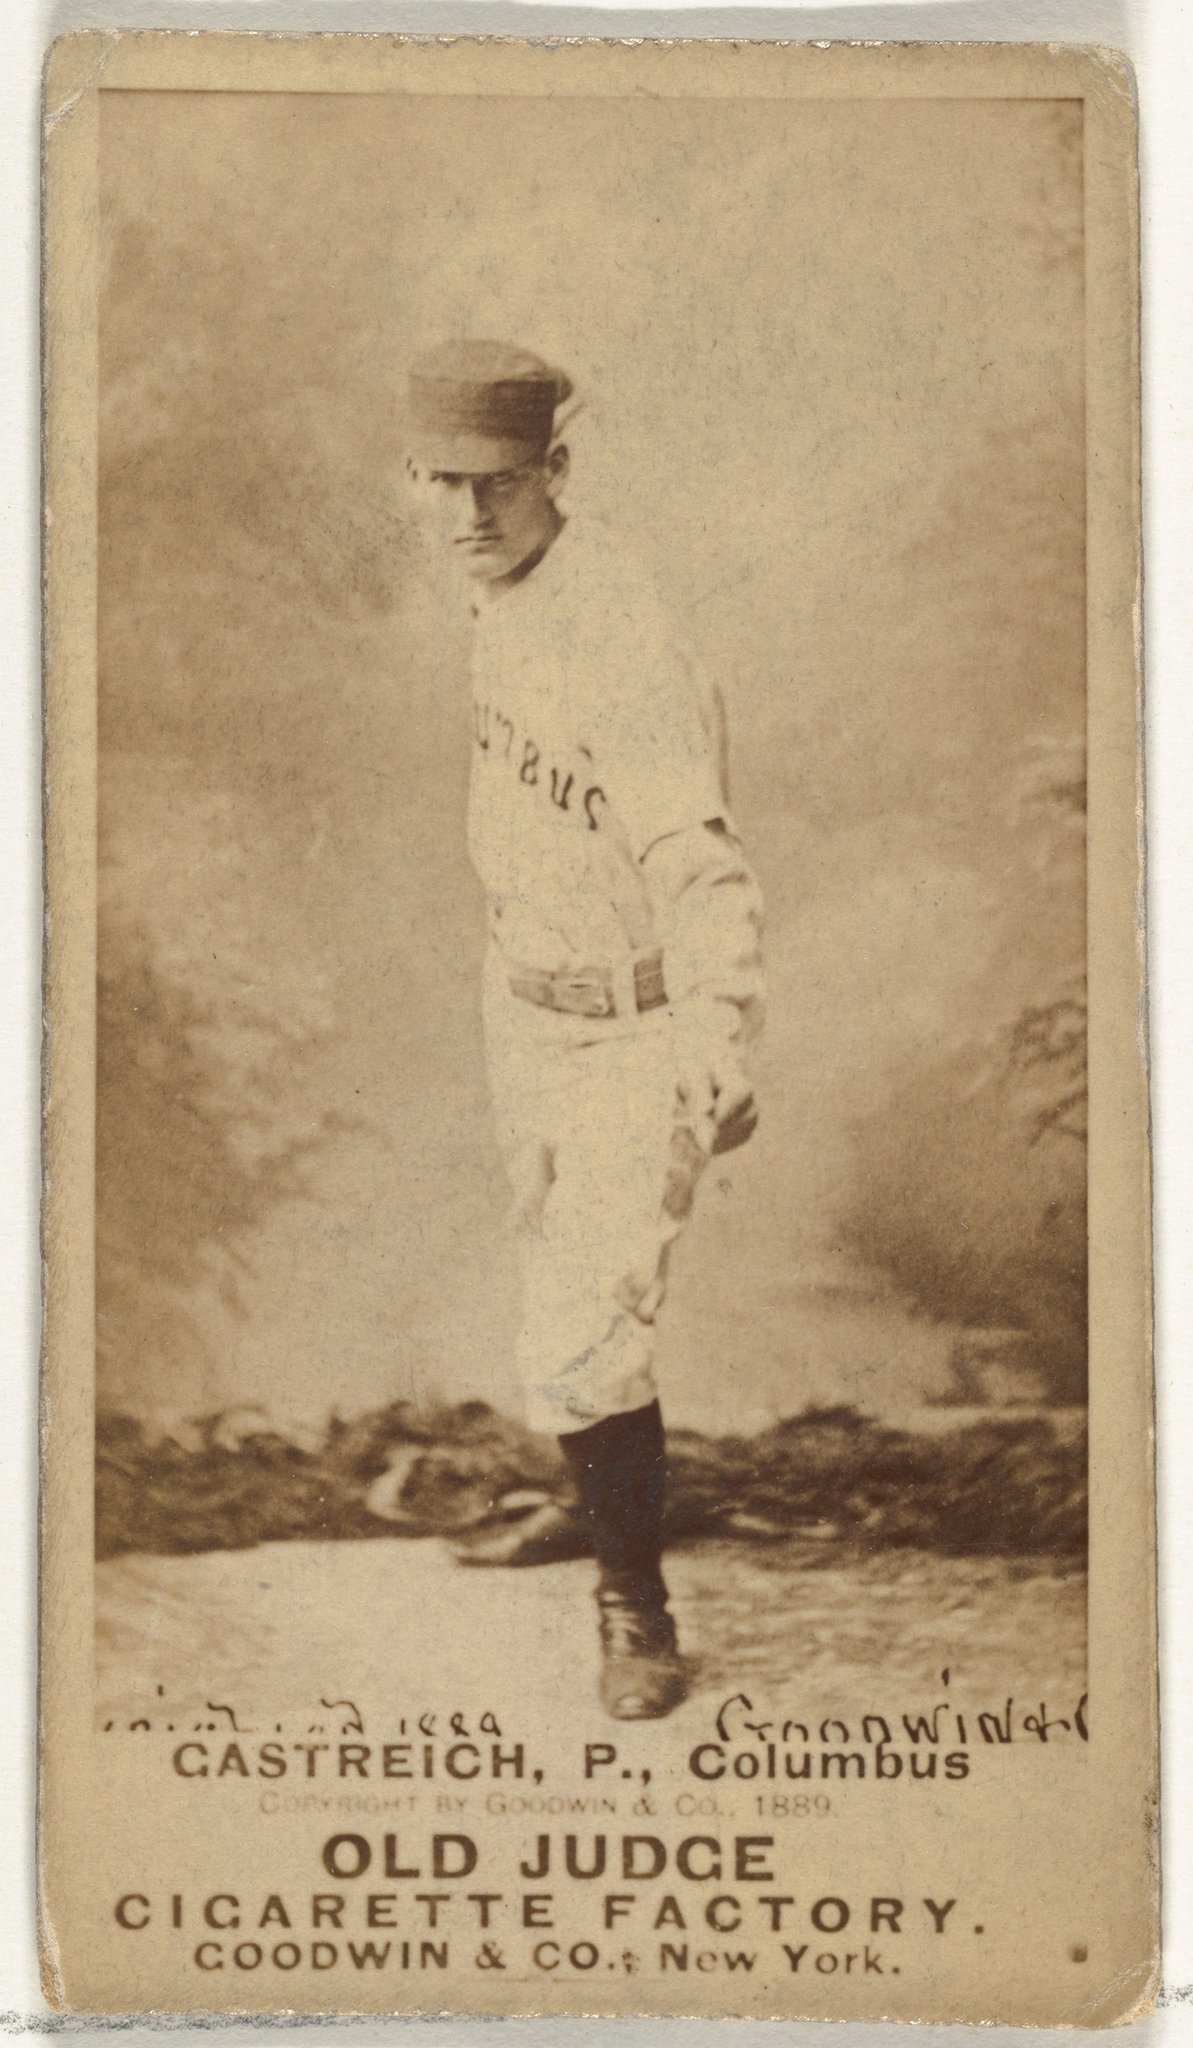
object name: baseball card, photograph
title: Henry Carl "Hank" Gastright, Pitcher, Cleveland, from the Old Judge series (N172) for Old Judge Cigarettes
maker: goodwin & company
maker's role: publisher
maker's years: 1850-1950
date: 1889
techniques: albumen silver print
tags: men,portraits,baseball,athletes